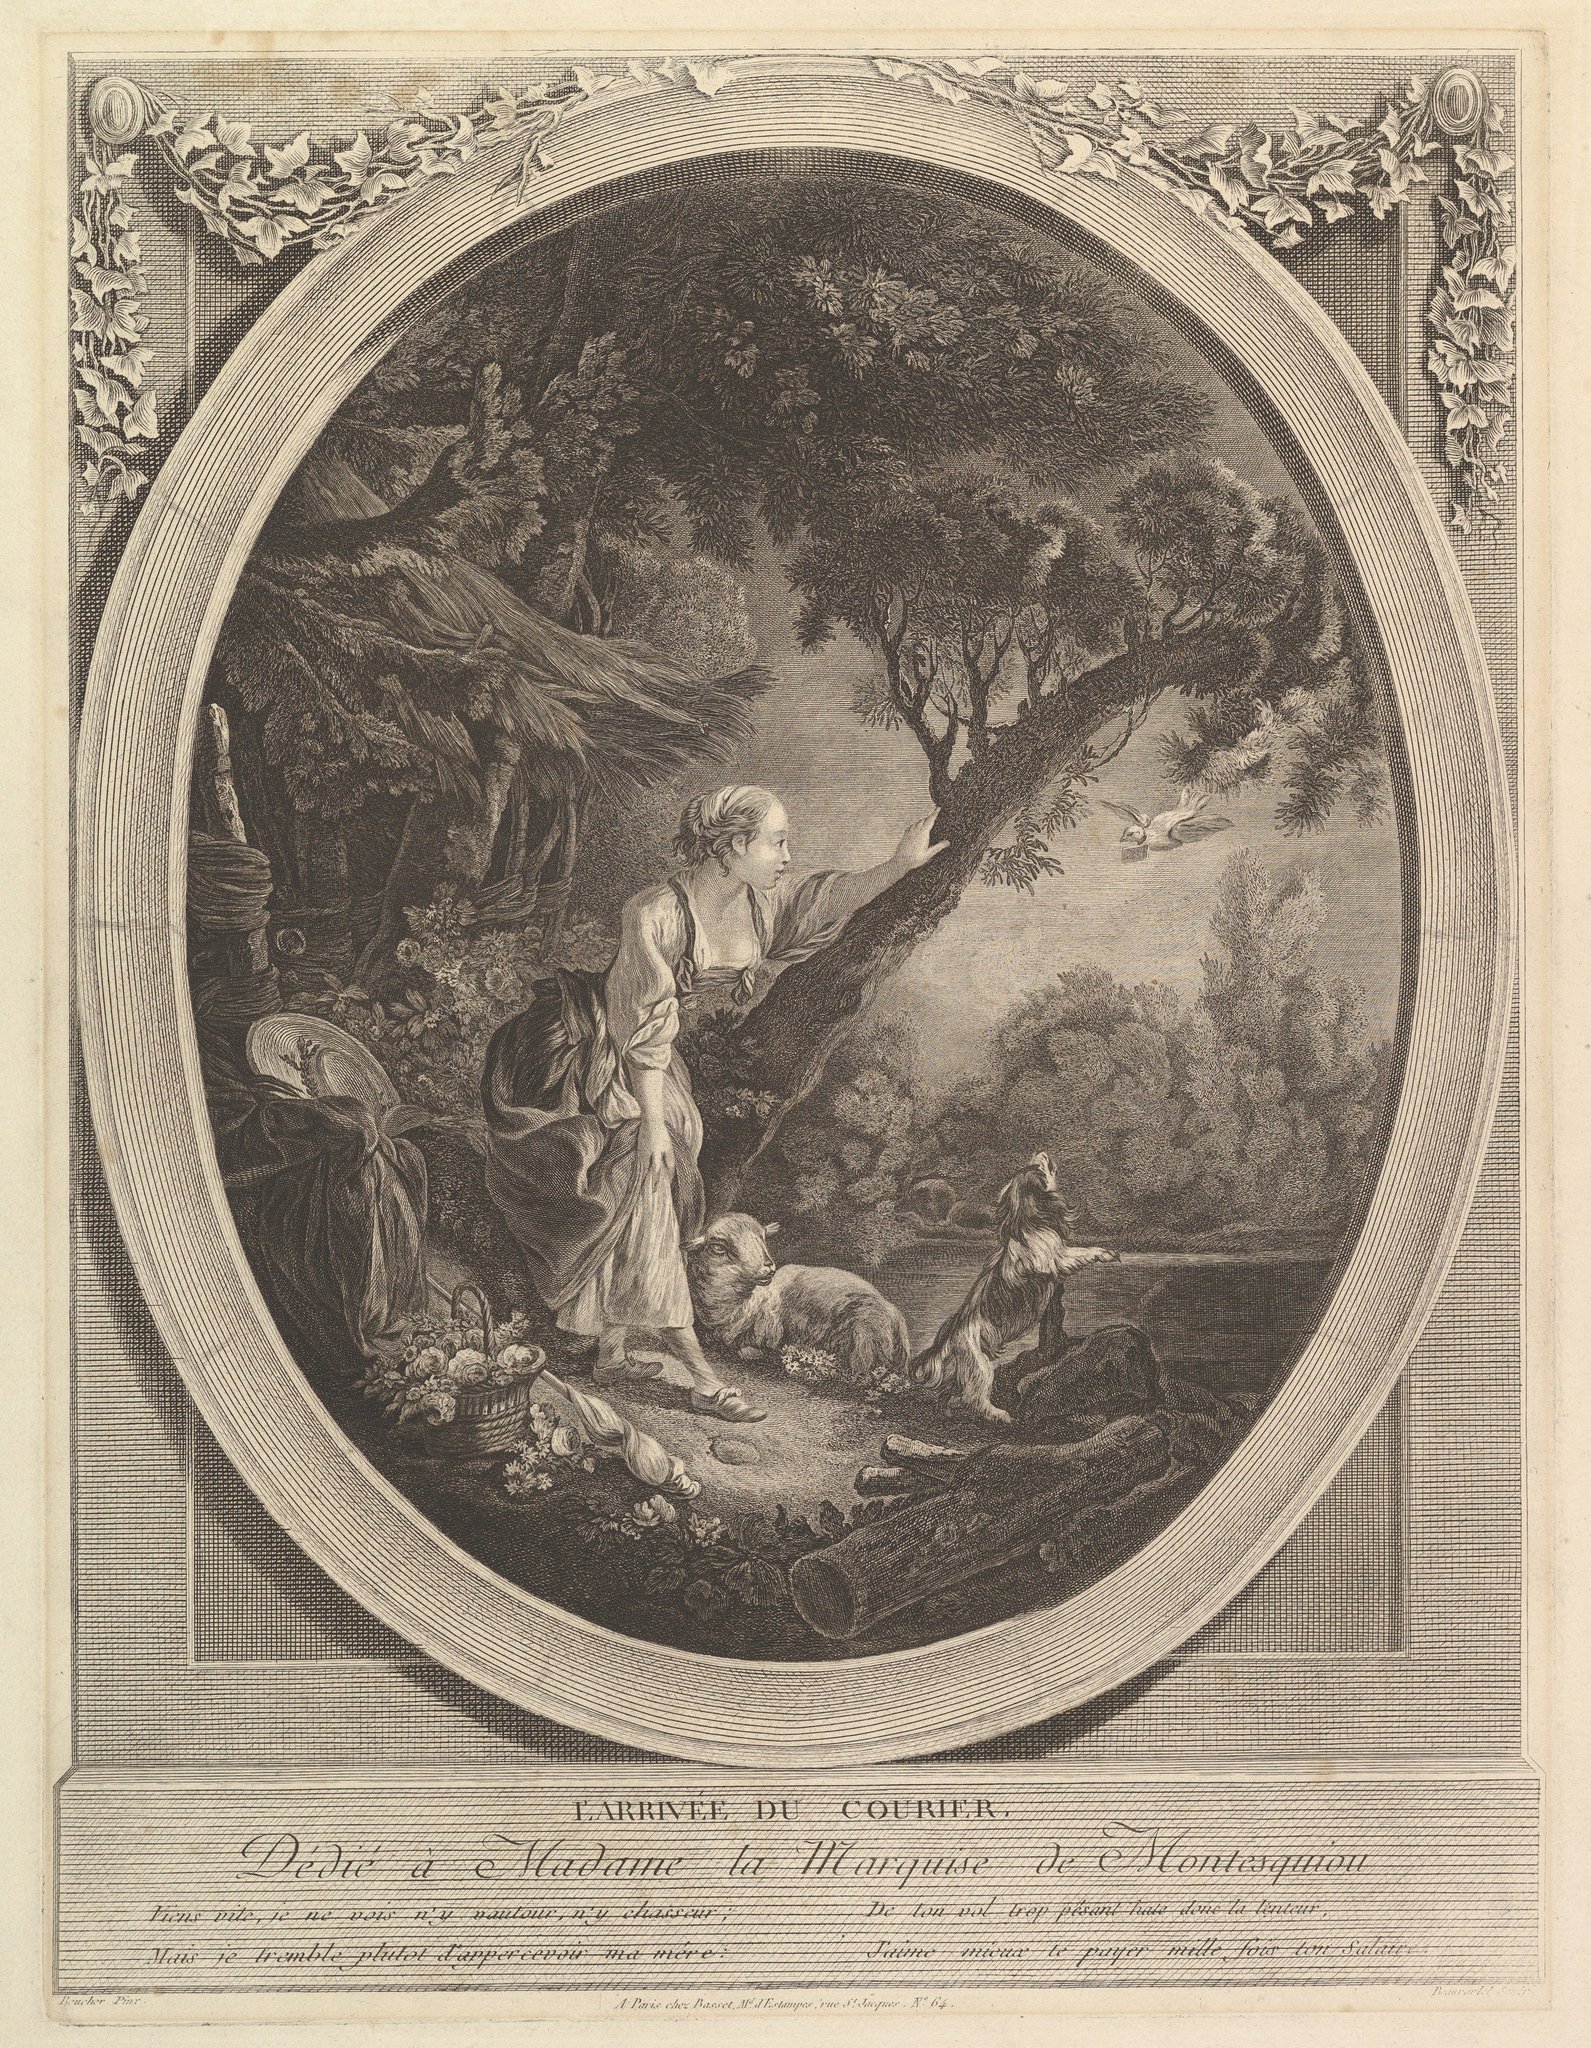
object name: print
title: L'Arivée du Courier (The Arrival of the Messenger)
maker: jacques firmin beauvarlet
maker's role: artist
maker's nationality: french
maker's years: 1731-1797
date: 1701-1800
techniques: engraving, etching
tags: birds,women,dogs,sheep,trees